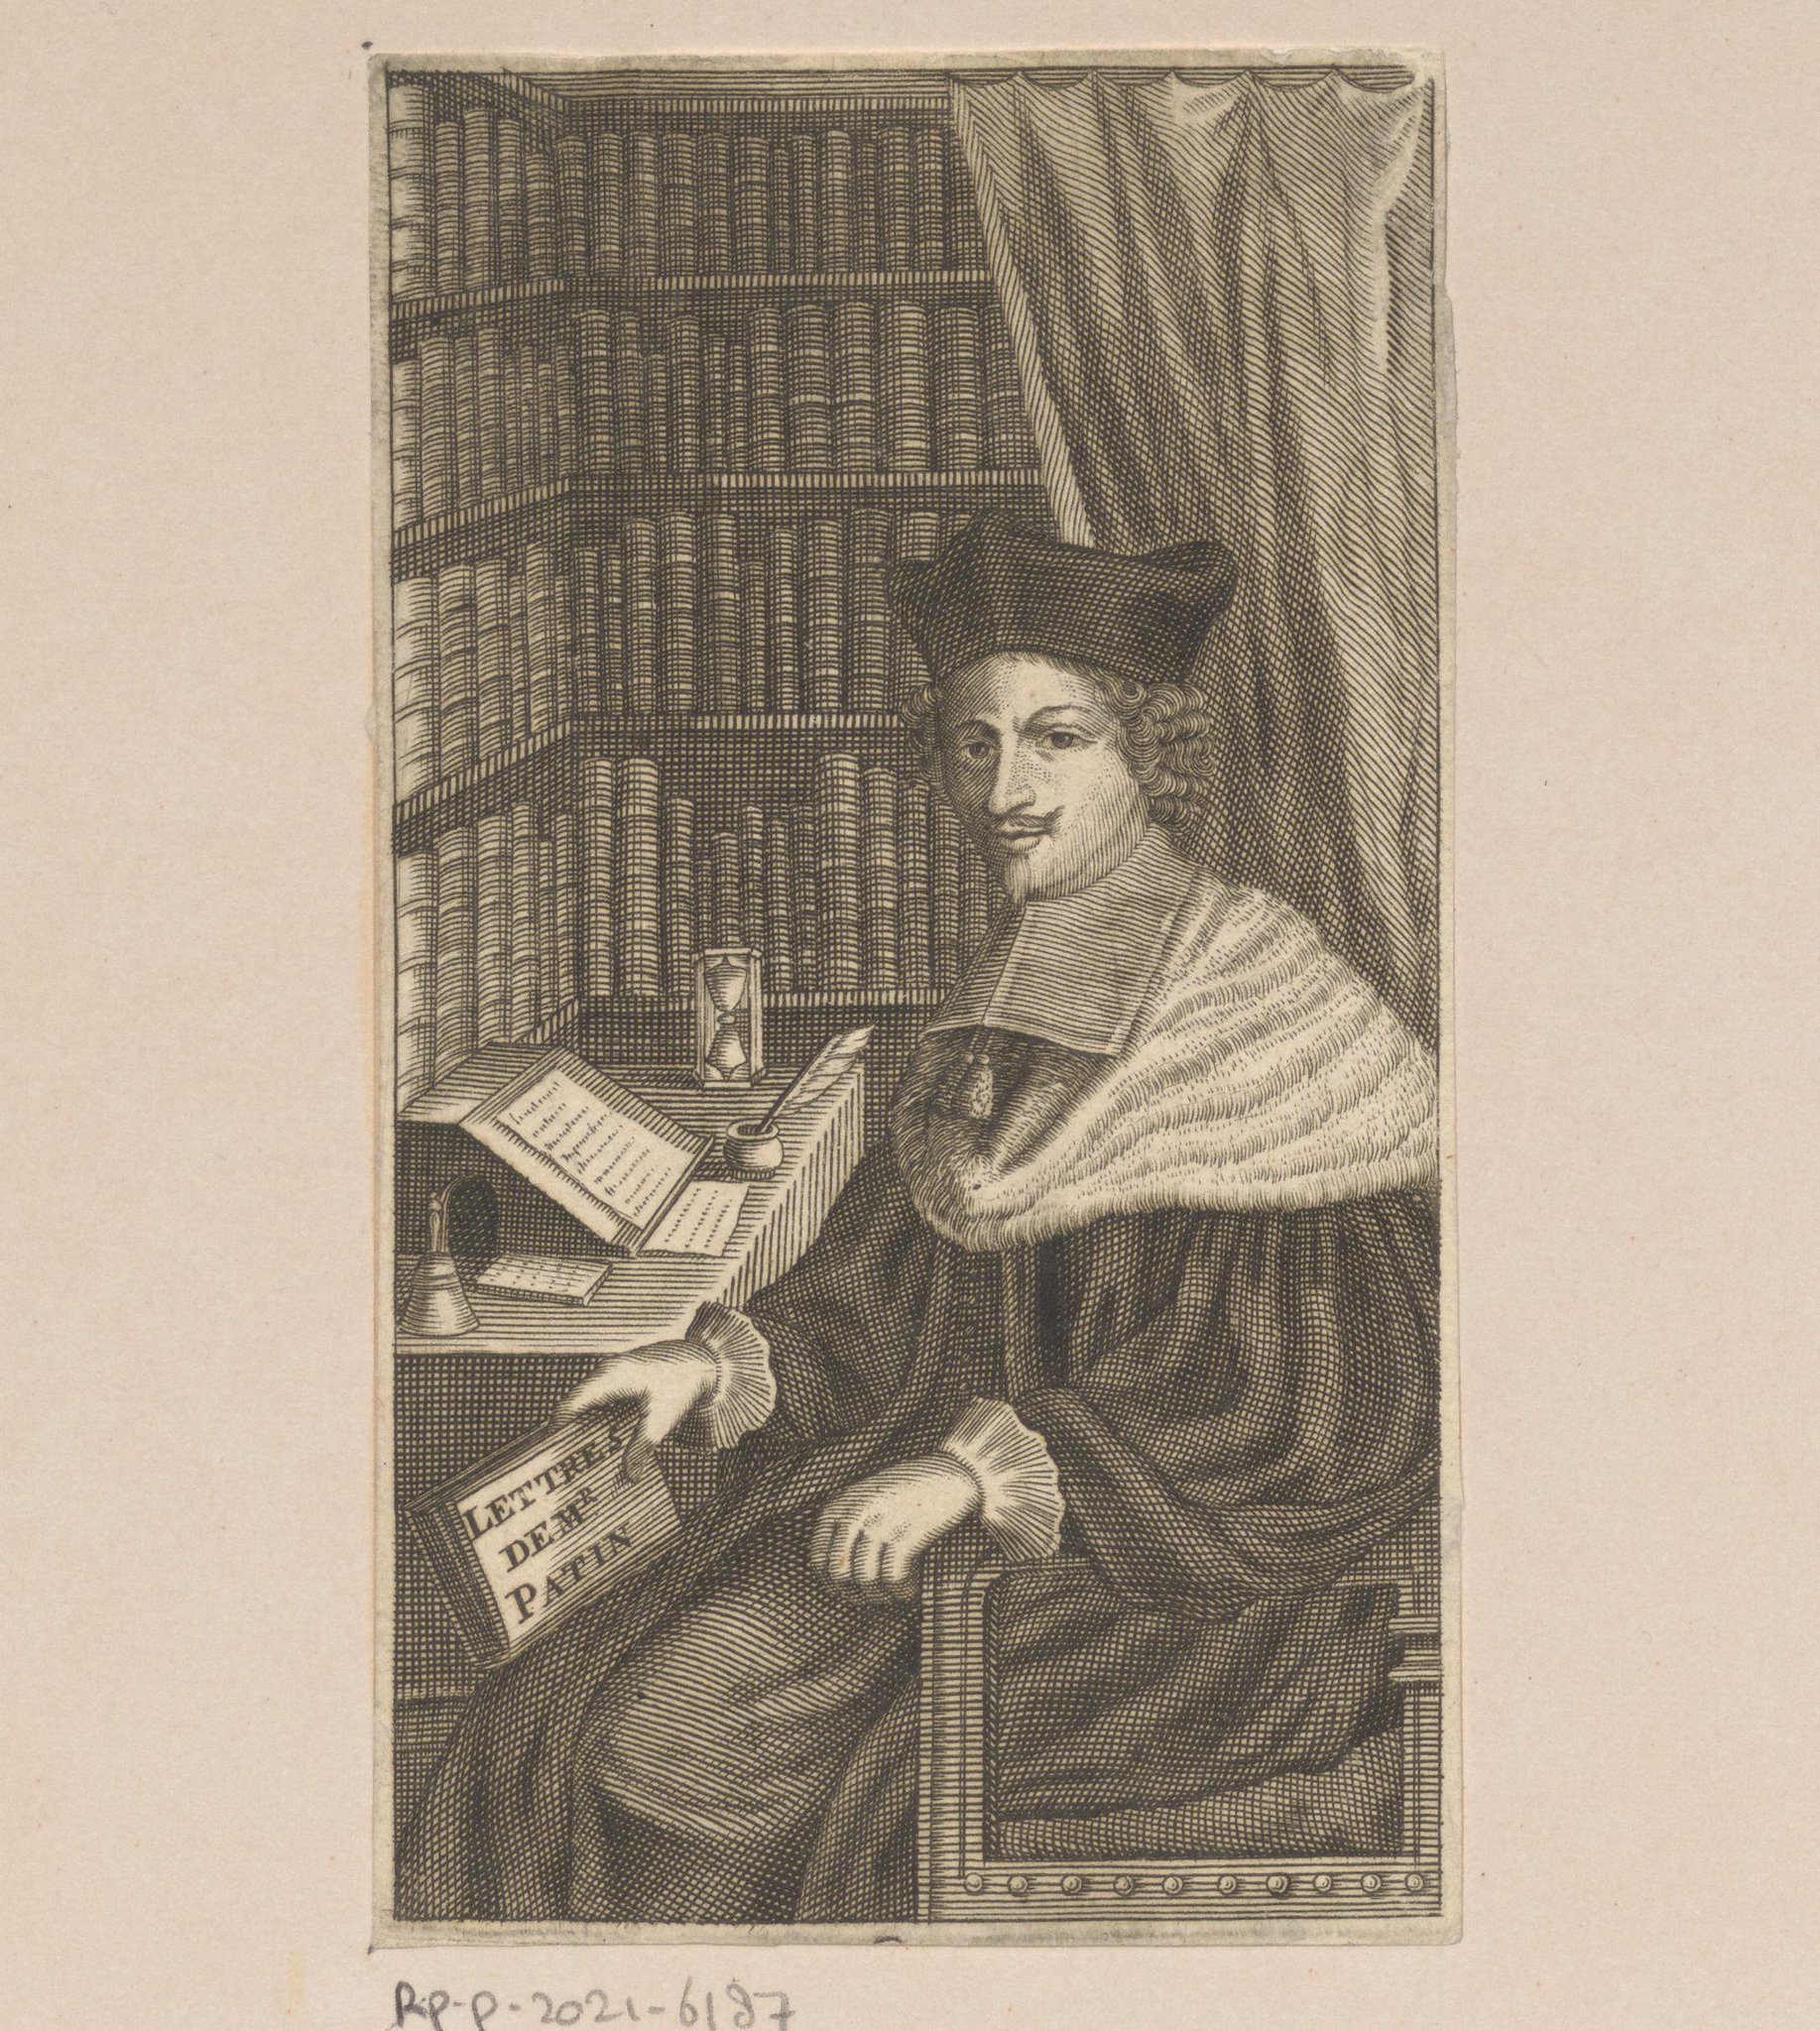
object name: titelblad, titelpagina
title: Portret van Guy Patin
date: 1691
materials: paper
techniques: engraving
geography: cologne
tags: adult man, historical persons, physician, doctor, study; 'studiolo'; library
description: Titelpagina voor: Patin, Guy. Lettres choisies de feu M. Guy Patin, docteur en medecine (...). 3 dln. Keulen: Pierre du Laurens, 1691, dl. 1.